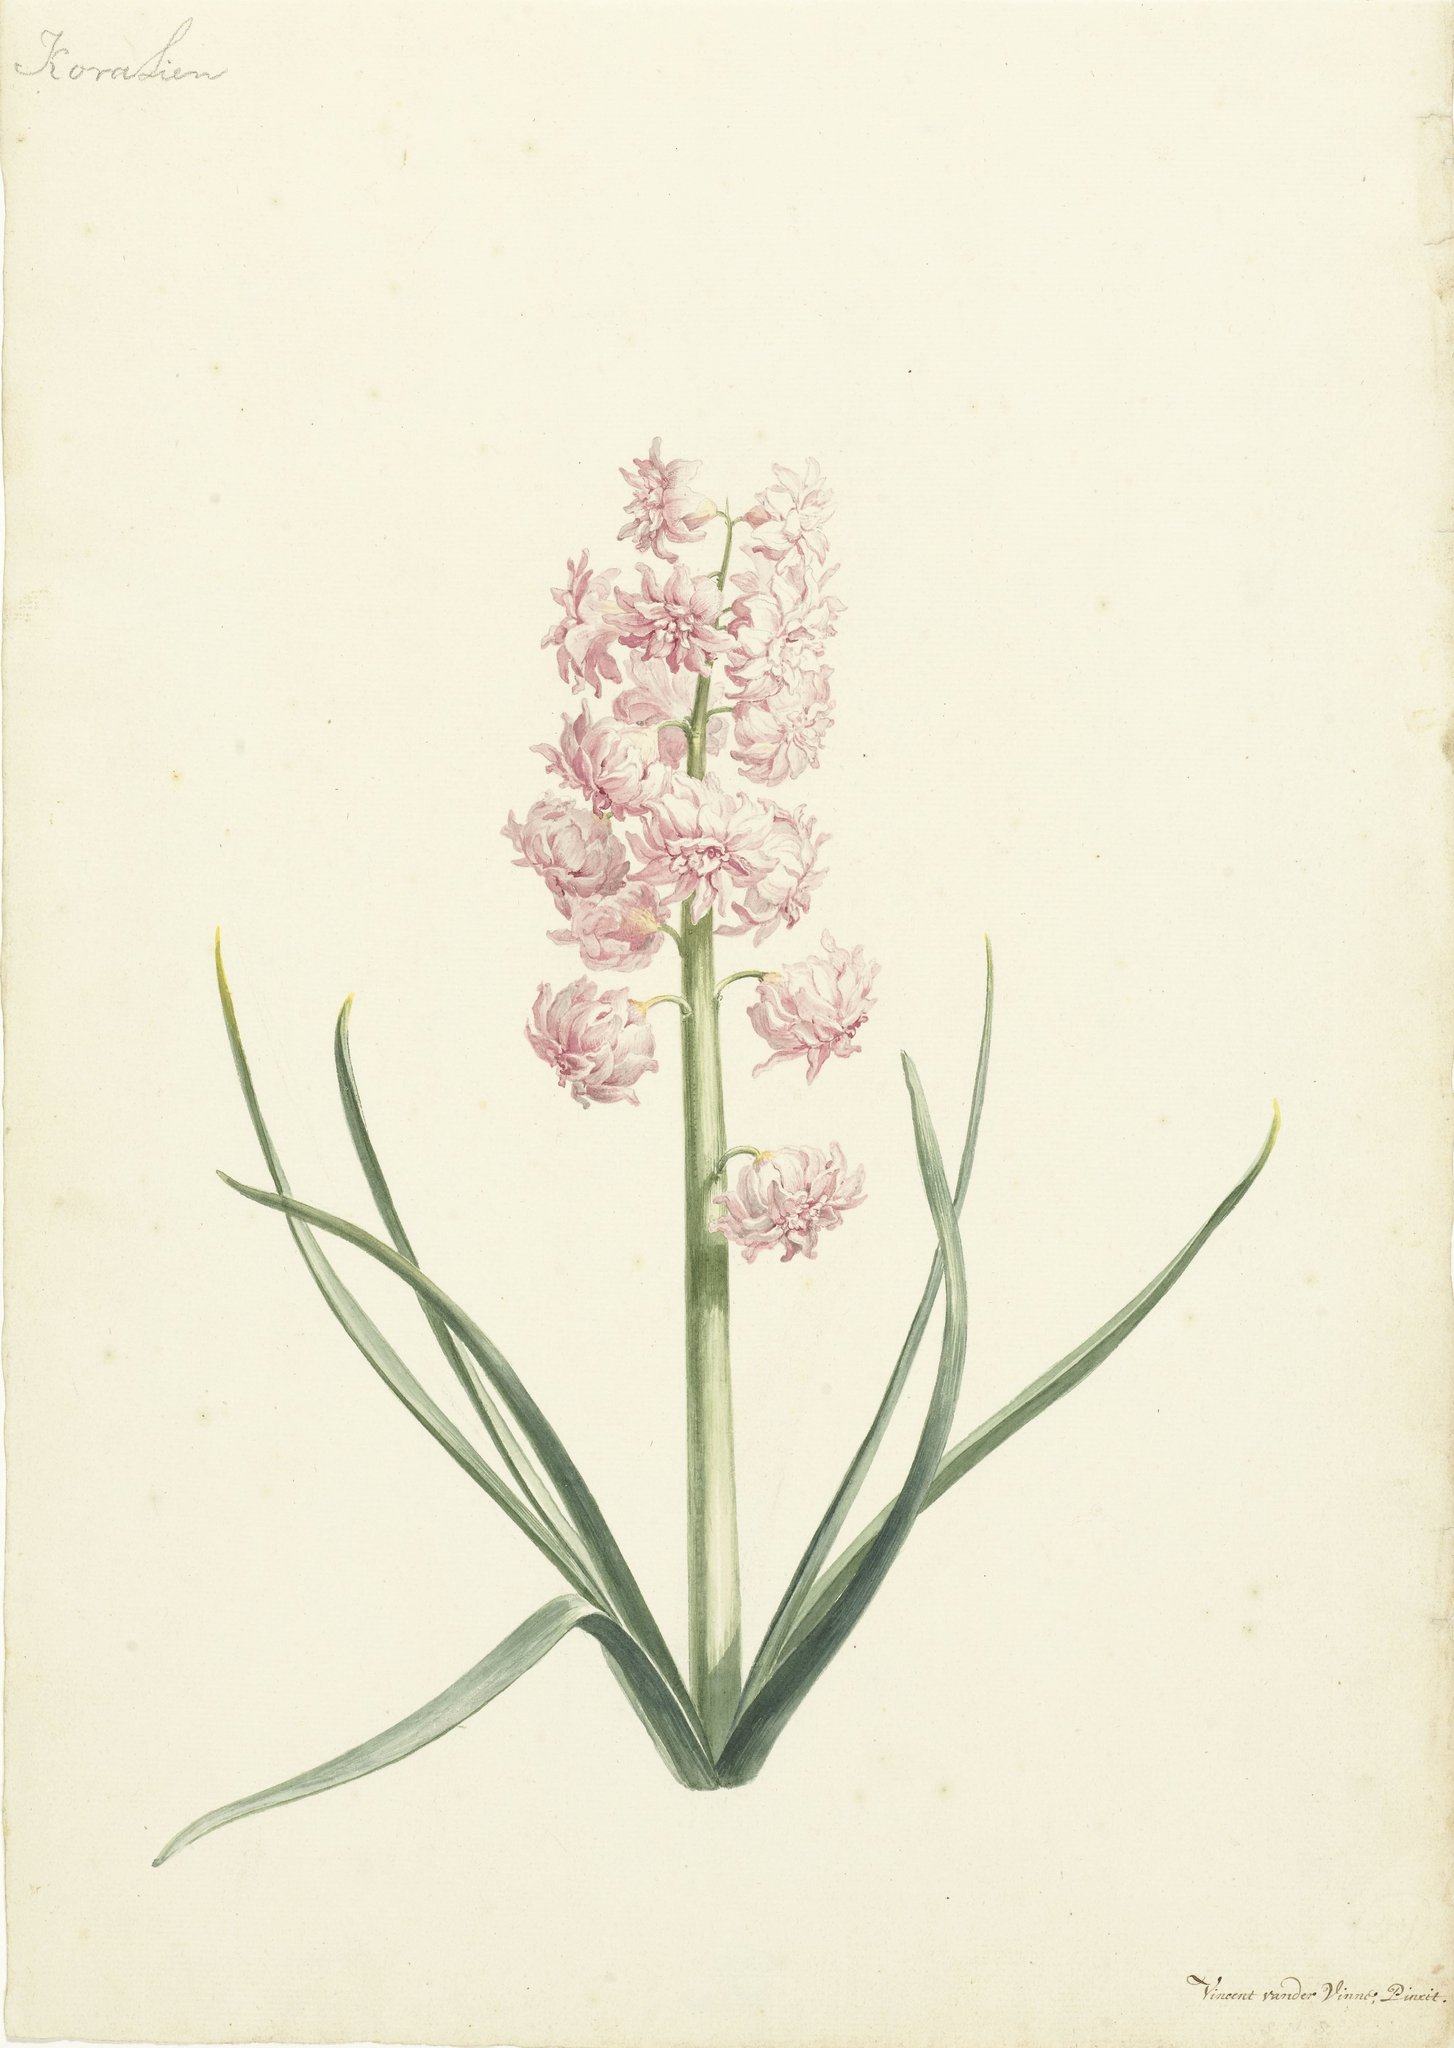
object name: watercolor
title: Hyacint Koralien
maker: vincent laurensz. van der vinne (ii)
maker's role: draughtsman, print maker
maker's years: 1686-1742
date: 1696-1742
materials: paper, pencil, watercolor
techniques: brush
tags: flowers: hyacinth